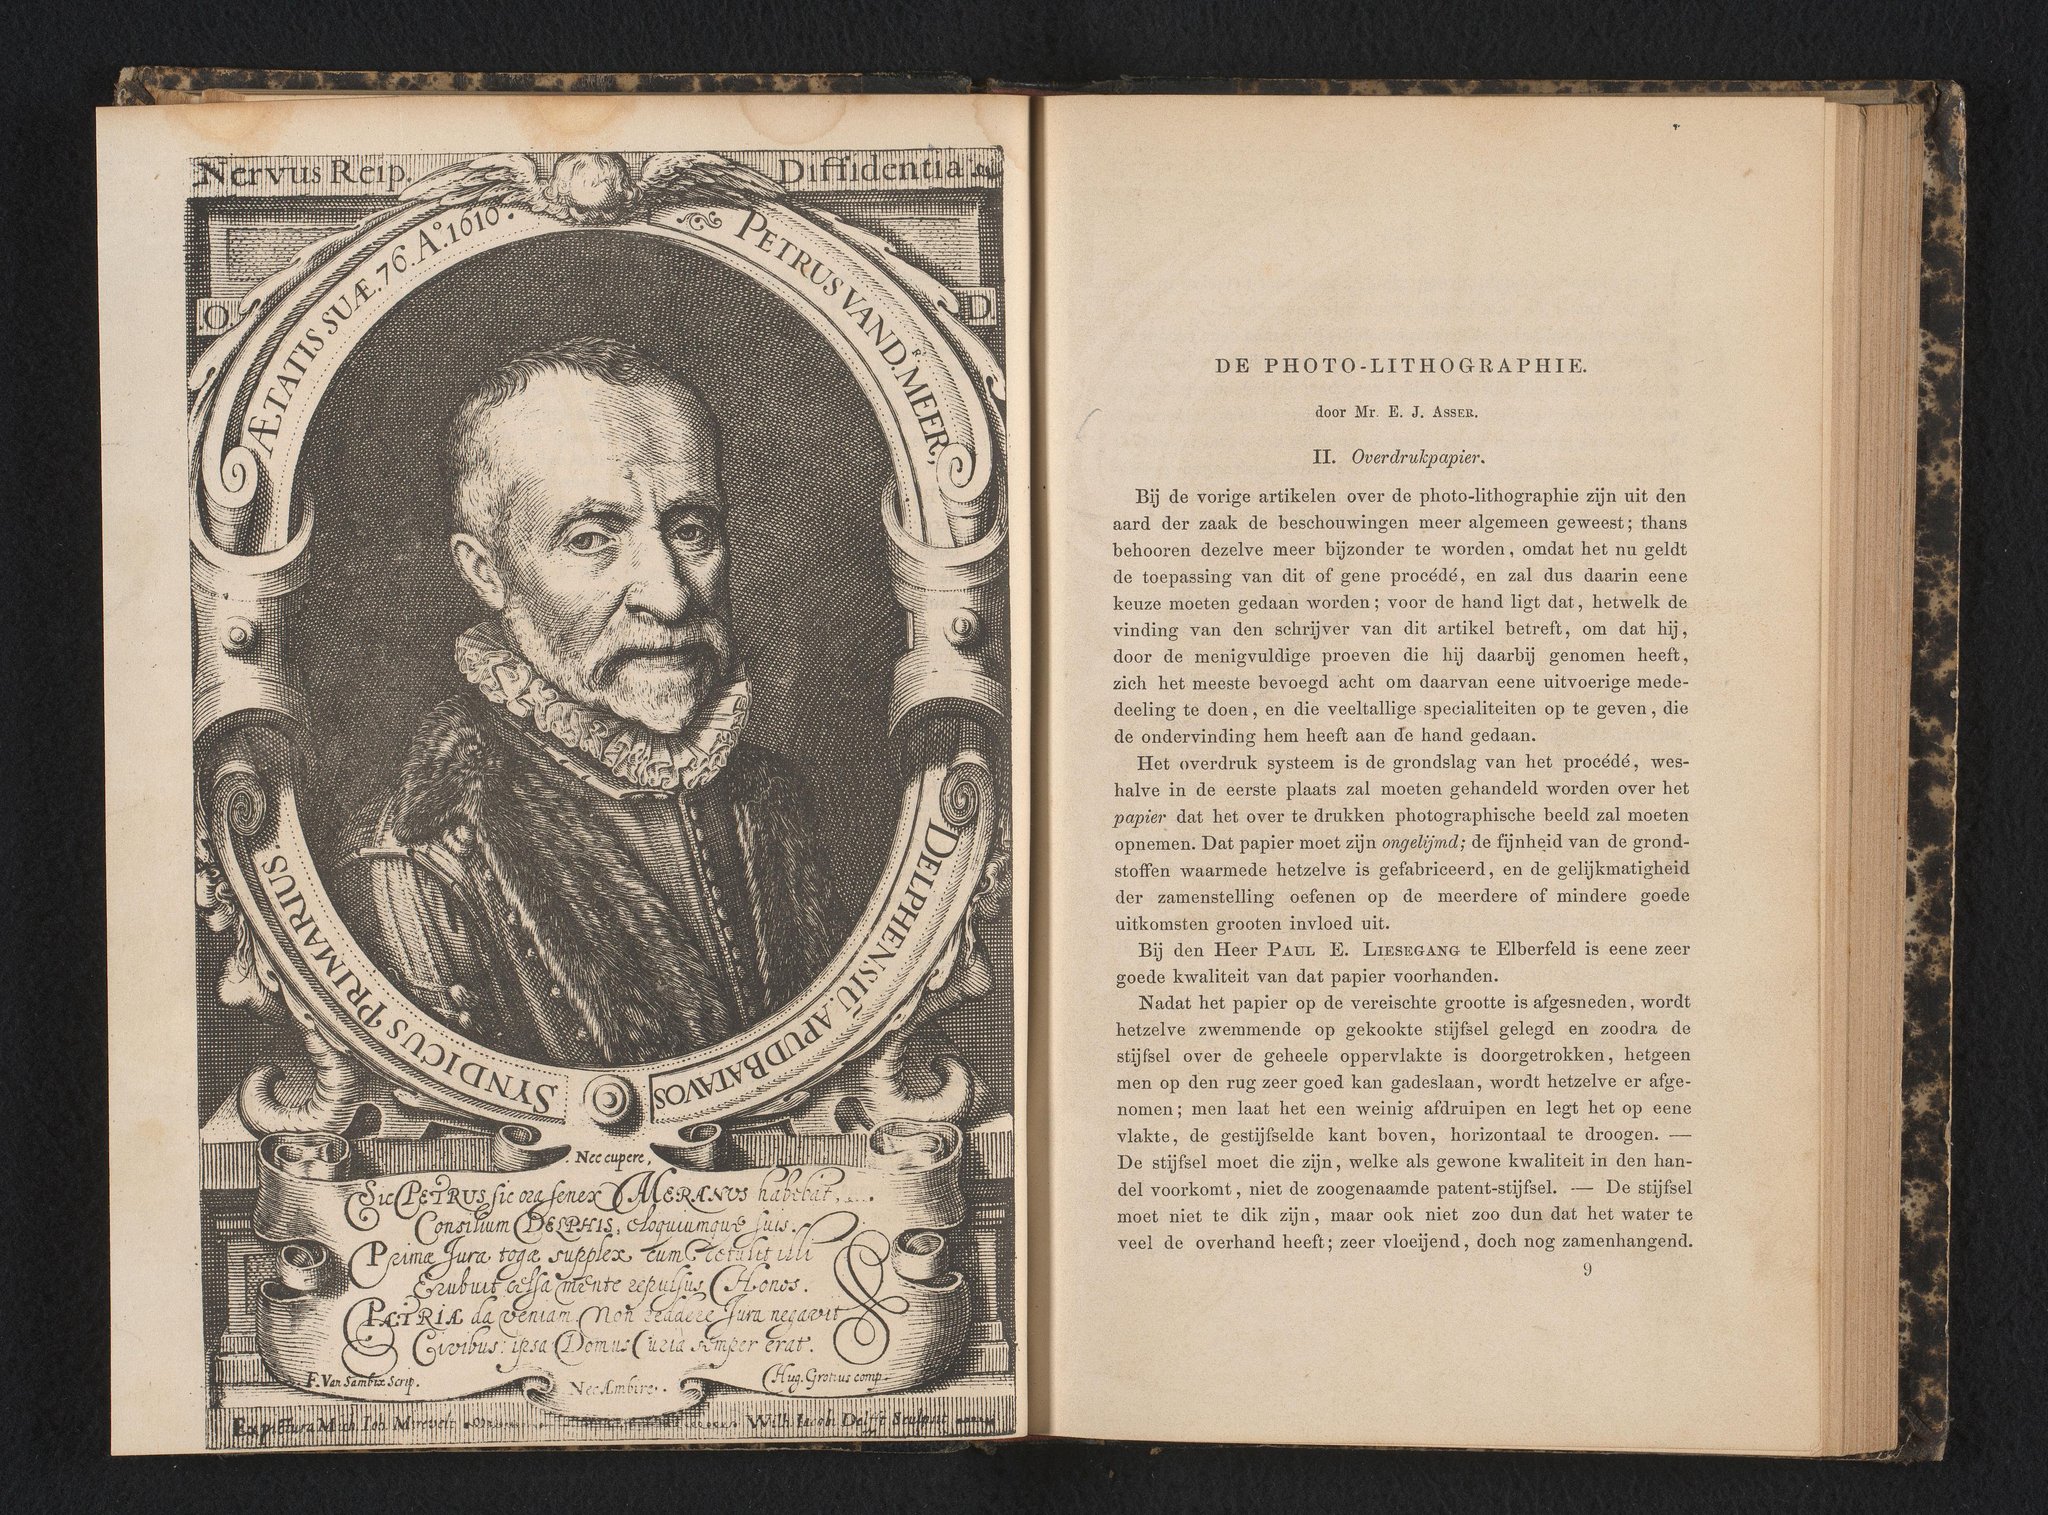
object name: reproduction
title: Fotoreproductie van een gegraveerd portret van Petrus van der Meer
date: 1859-1864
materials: paper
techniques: photolithography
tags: historical persons